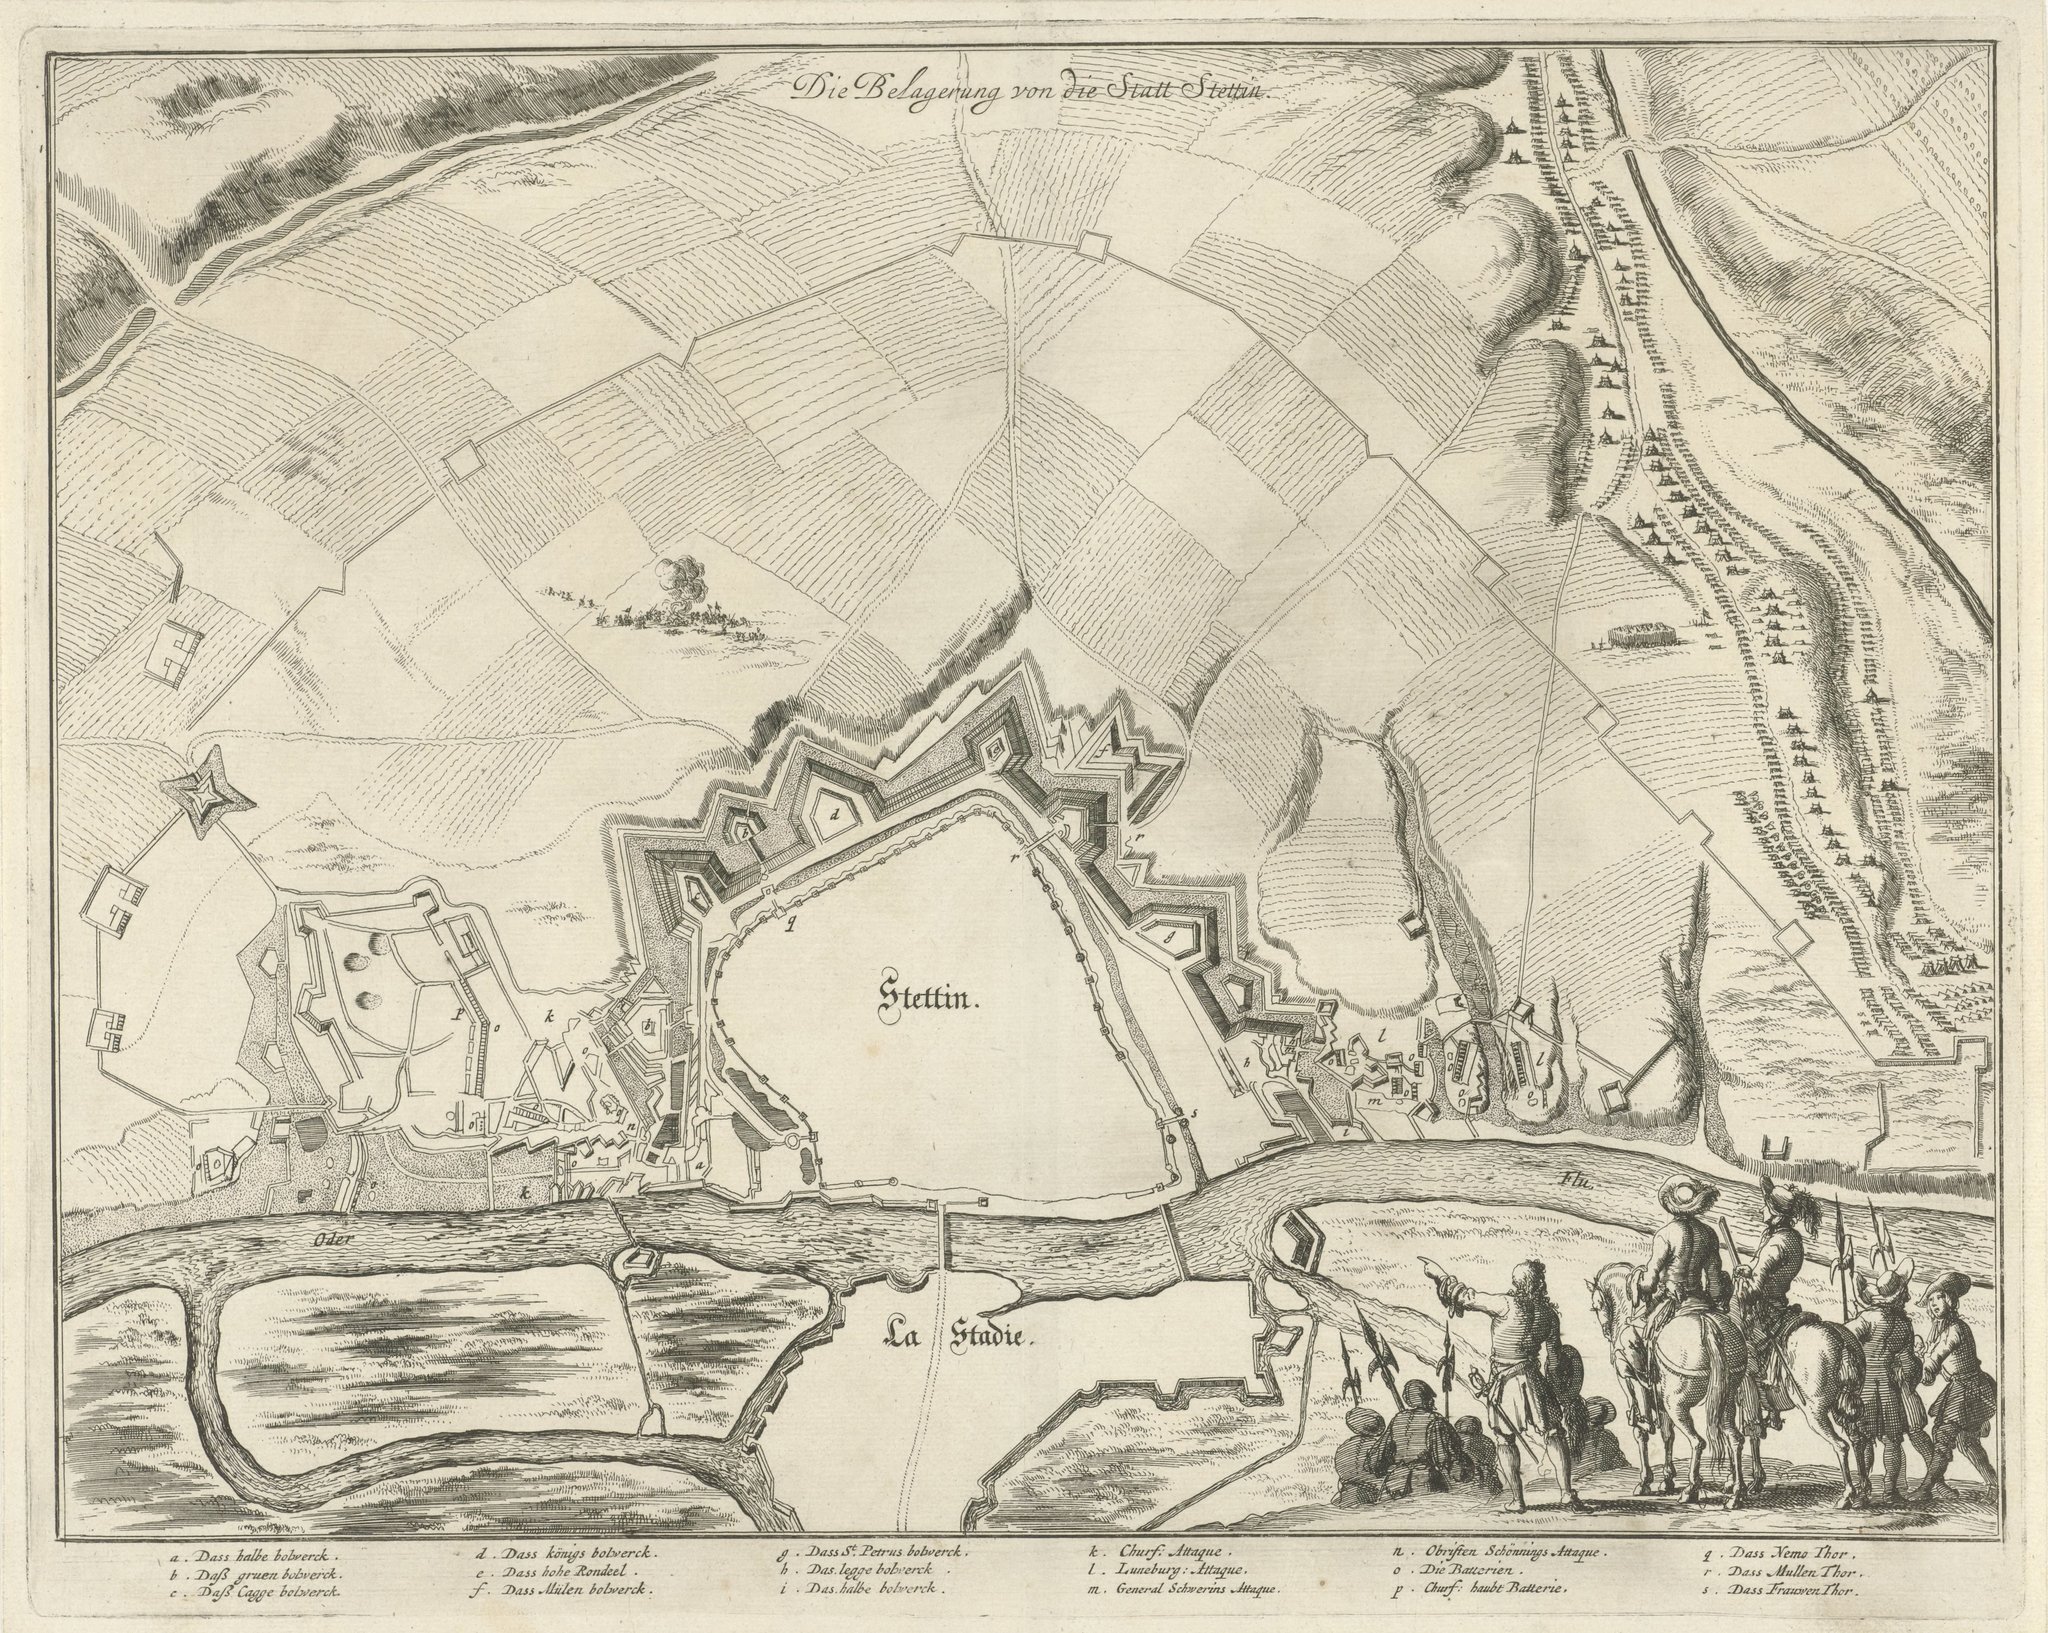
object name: book illustration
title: Beleg van Stettin, 1677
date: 1683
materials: paper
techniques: etching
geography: amsterdam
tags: bombardment ~ siege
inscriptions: collector's mark: Lugt 2228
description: Illustratie opgenomen in: Valckenier, Petrus. Das verwirrte Europa. Oder Politische und historische Beschreibung der in Europa, 3 dln, deel III, p. 214. Amsterdam: wed. Joannes van Someren, wed. Dirk en Hendrick Boom, 1683.